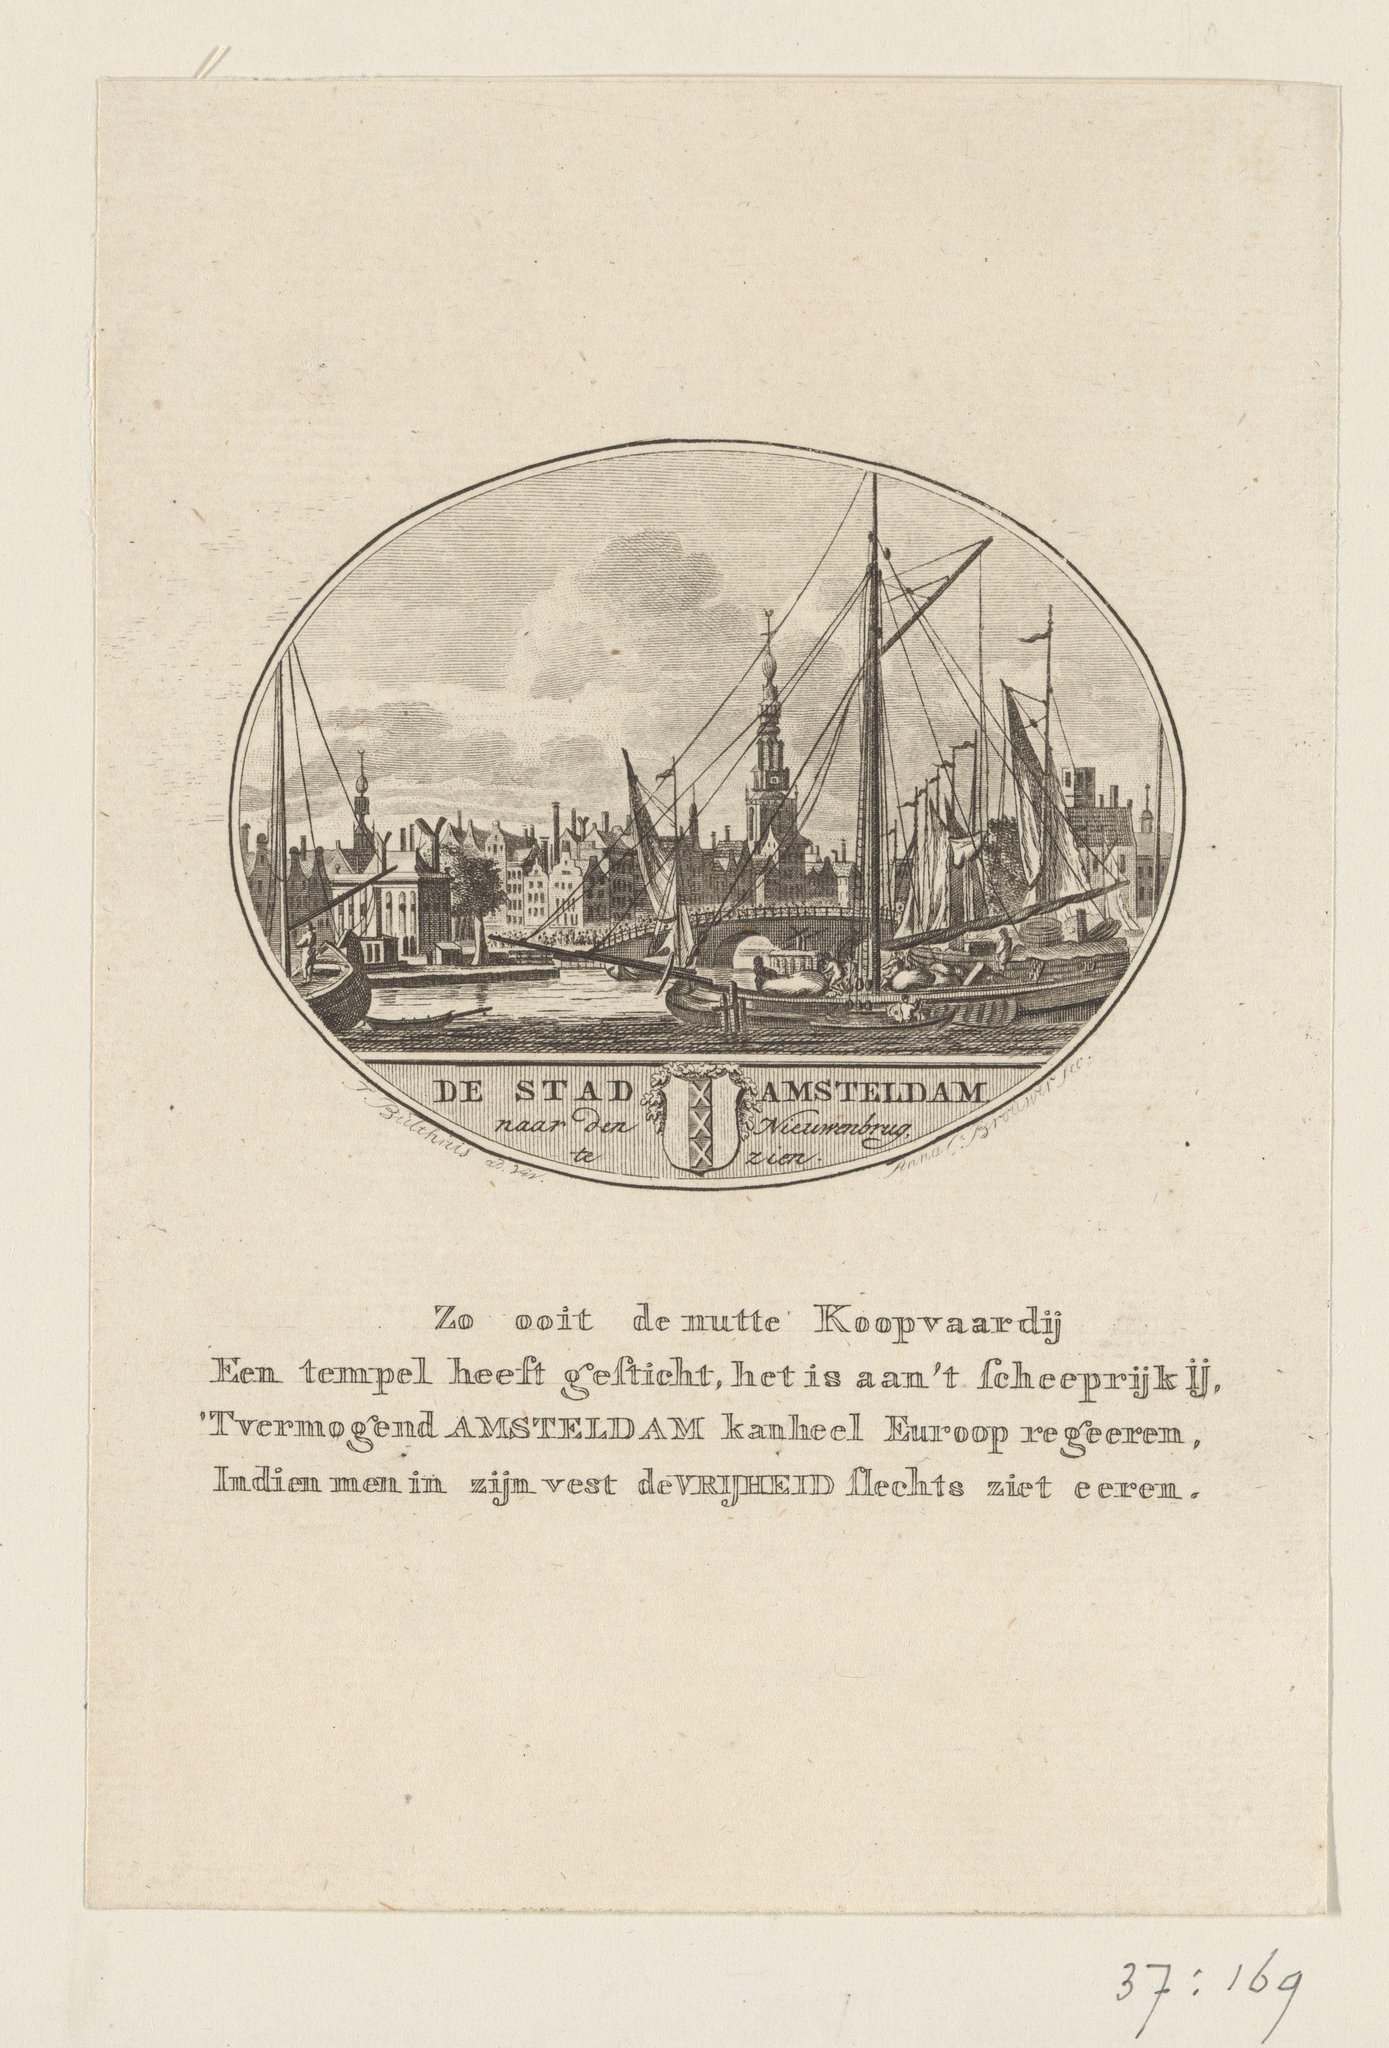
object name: print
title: Gezicht op Damrak vanaf het IJ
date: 1795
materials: paper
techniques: engraving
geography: amsterdam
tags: sailing-ship, sailing-boat, bridge in city across river, canal, etc., prospect of city, town panorama, silhouette of city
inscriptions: collector's mark: Lugt 2228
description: Prent uit: Ollefen, L. van. De Nederlandsche stad- en dorpbeschrijver. 8 dln. Amsterdam: H.A. Banse, 1793-1801, dl. 3 (1795), p. 16-17.